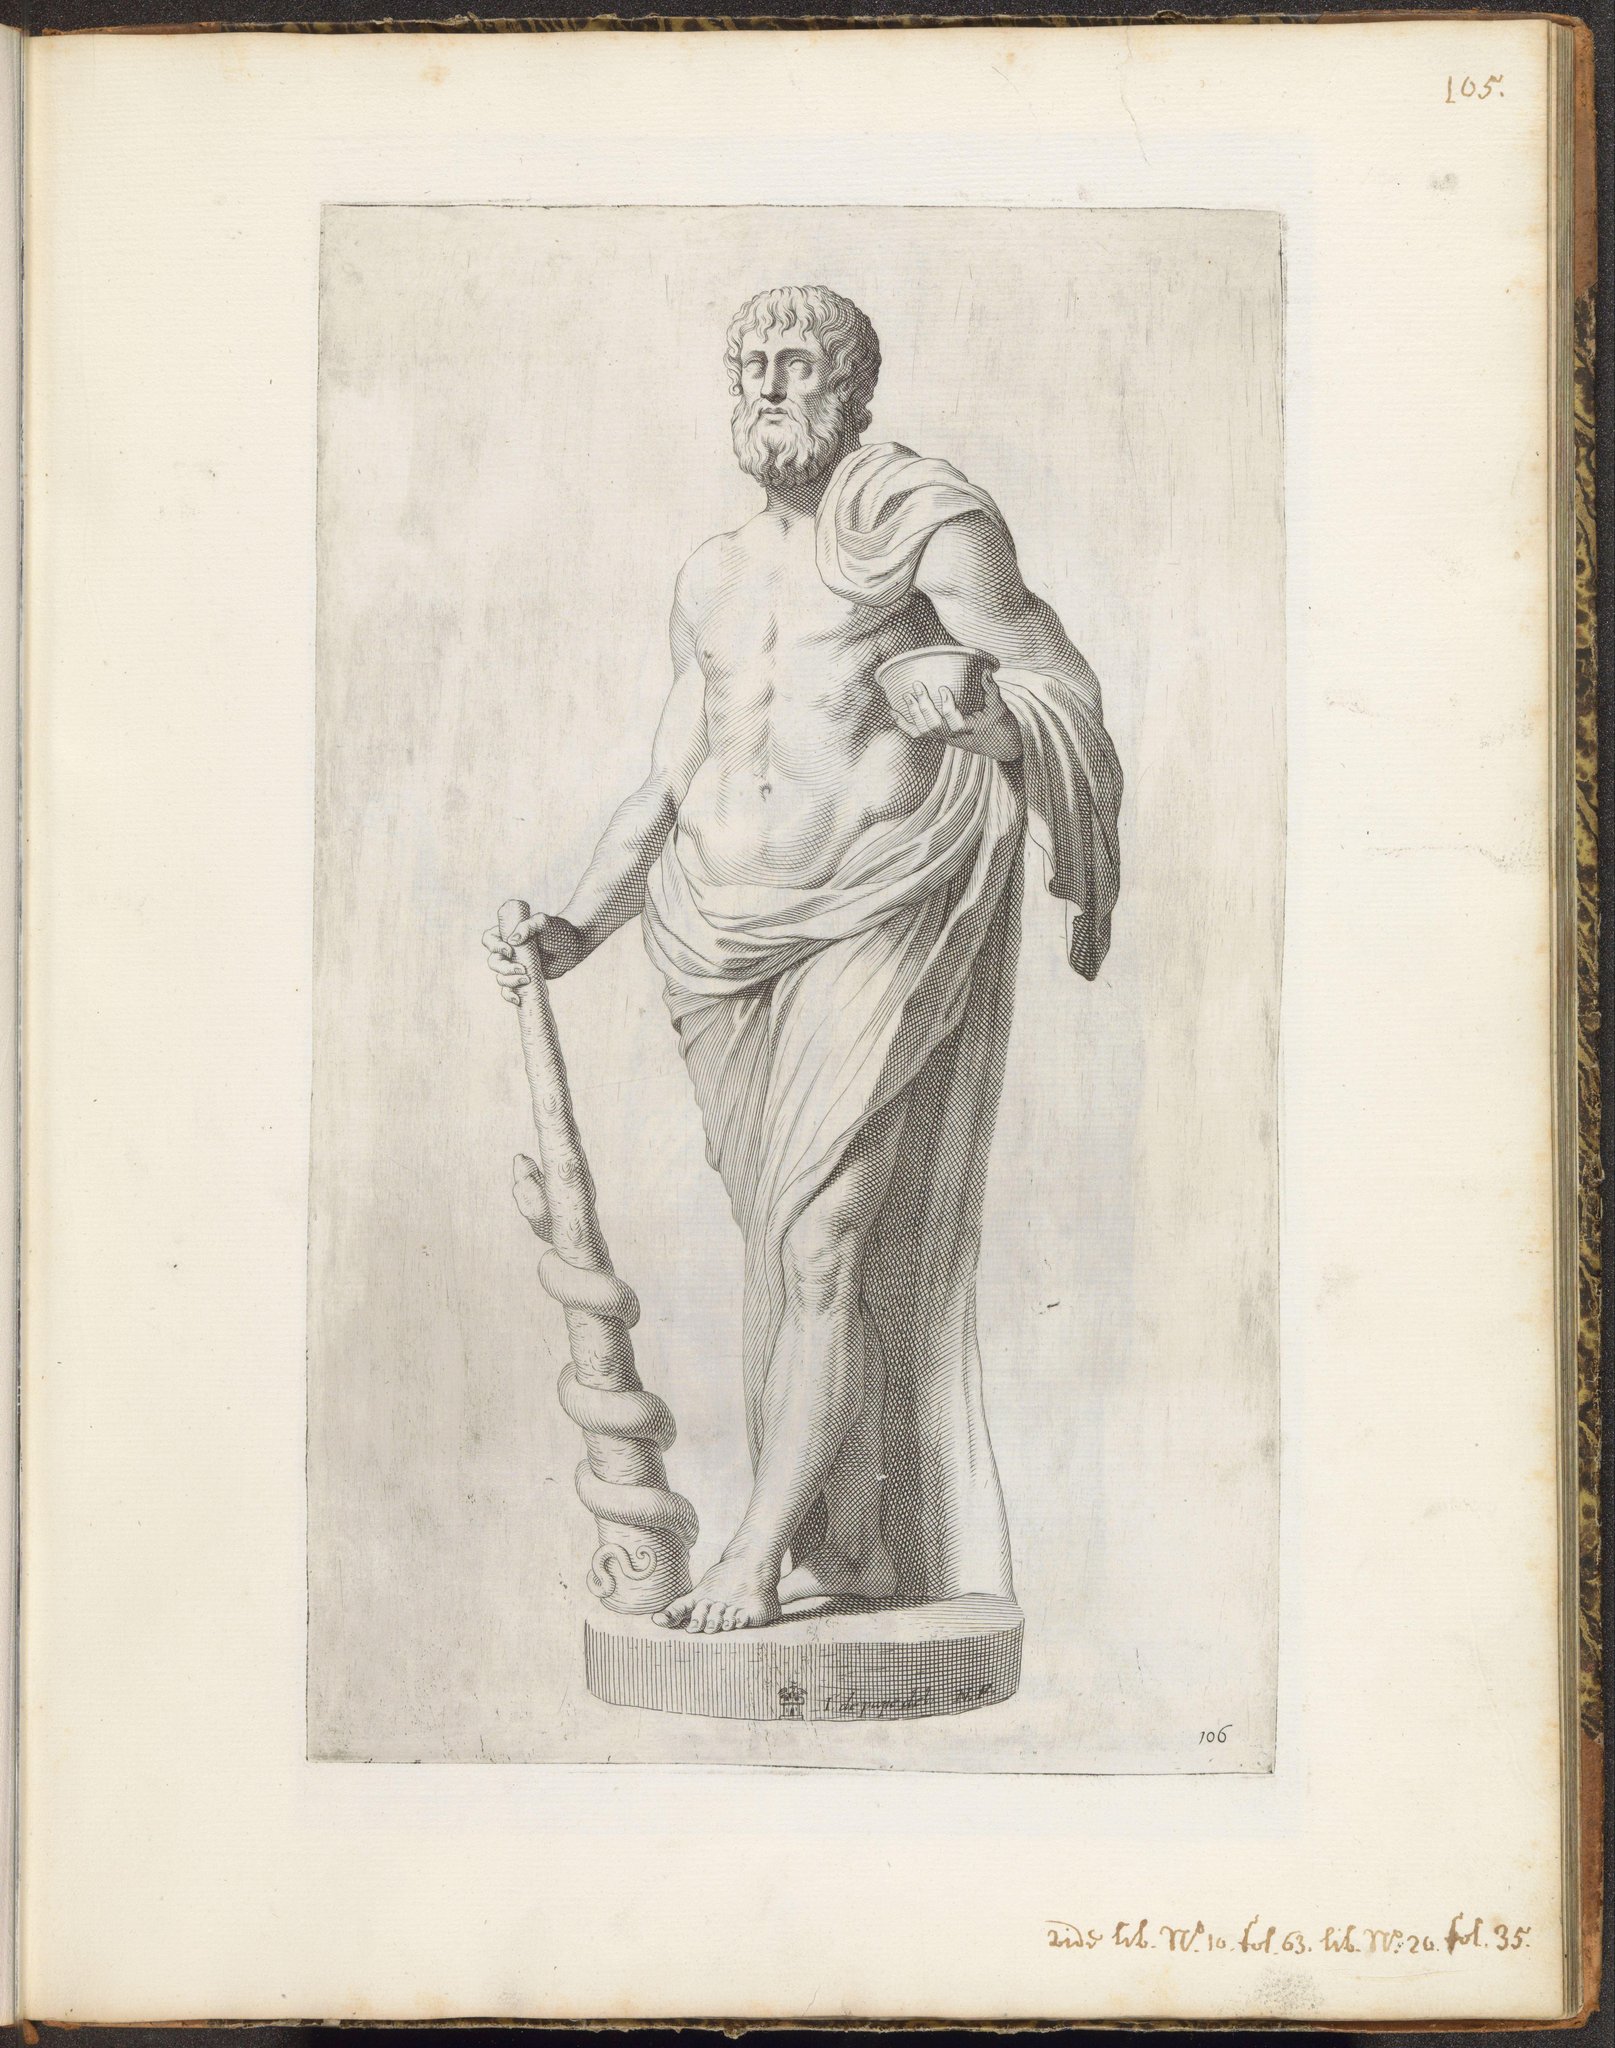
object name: print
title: Galleria Giustiniana del Marchese Vincenzo Giustiniani I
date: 1636-1647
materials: paper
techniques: engraving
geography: rome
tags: piece of sculpture, reproduction of a piece of sculpture, (story of) aesculapius (asclepius)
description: Standbeeld van Aesculapius met zijn door een slang omwikkelde staf in zijn linkerhand. In zijn rechterhand draagt hij een kom. Op de basis het wapen van Vincenzo Giustiniani. Prent maakt deel uit van een album met een serie prenten naar de sculpturen in de verzameling in de Galleria Giustiniani te Rome.